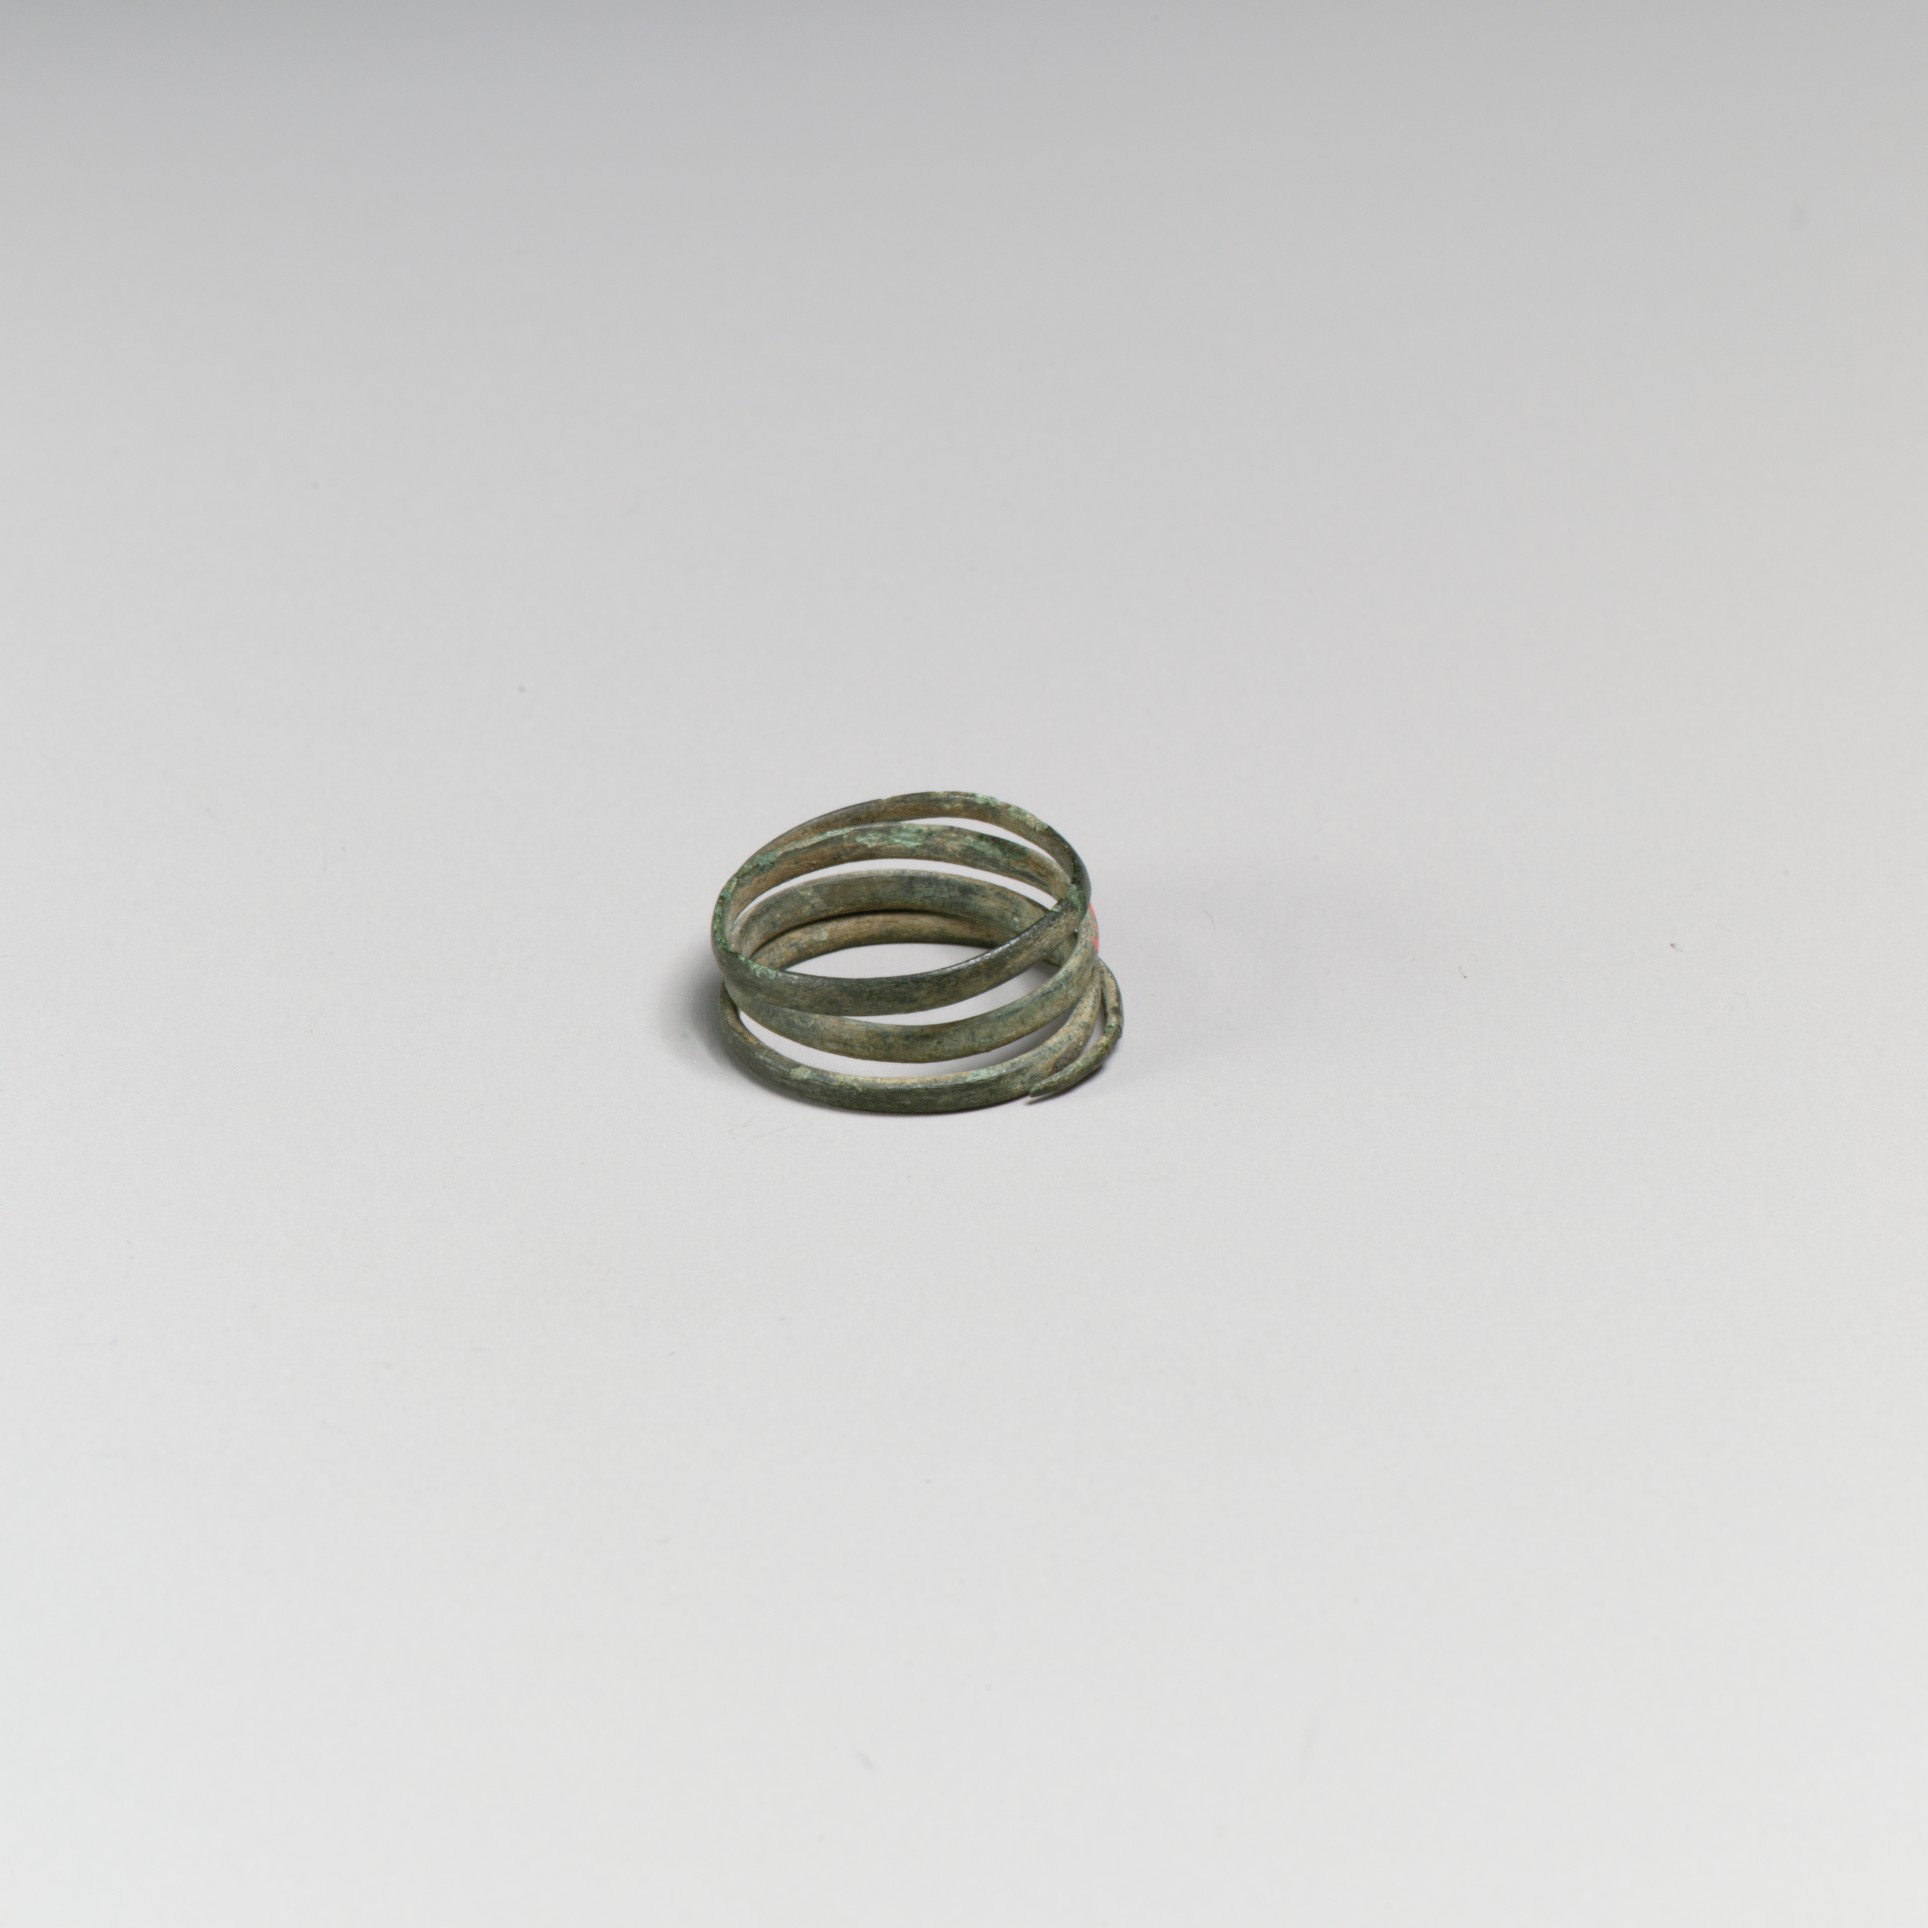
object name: spiral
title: Two bronze spirals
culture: minoan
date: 2900-1050 BCE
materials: bronze